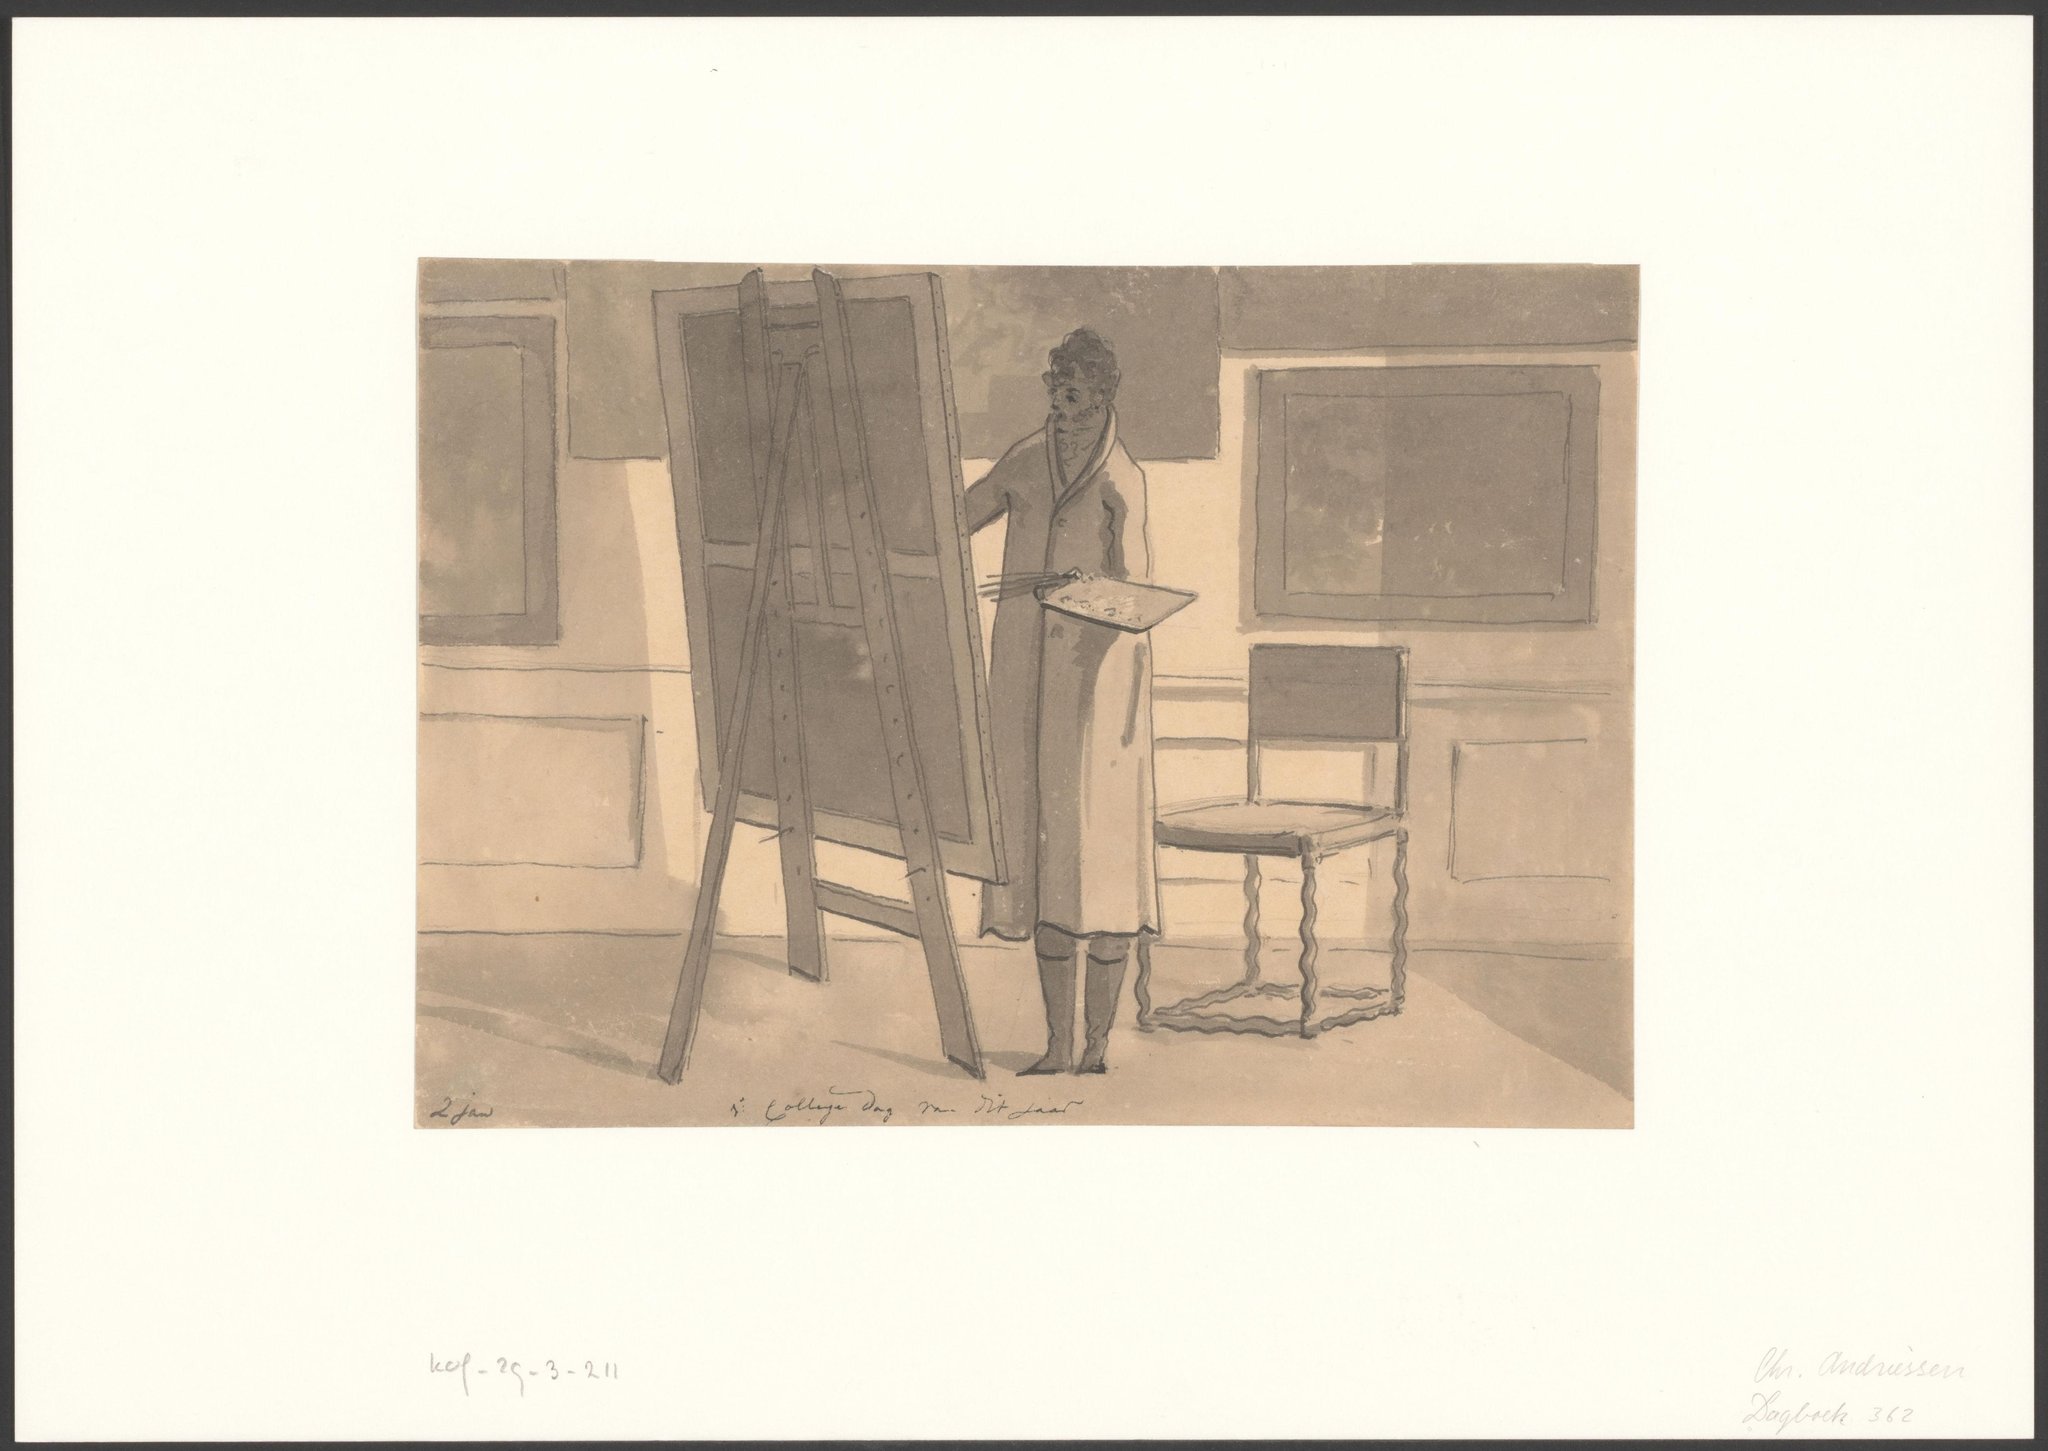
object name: drawing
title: Christiaan Andriessen schildert op de eerste bijeenkomst van het vrouwencollege in 1806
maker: christiaan andriessen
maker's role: draughtsman, print maker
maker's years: 1775-1846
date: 1806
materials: ink, paper, pencil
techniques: brush, pen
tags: amsterdam, print maker, draughtsman, christiaan andriessen, artist at work, in his workshop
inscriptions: inscription, signature: ‘J Andriessen’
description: Christiaan Andriessen richtte met zijn vader het Vrouwencollege op. Op de Tekenacademie, werden er alleen mannelijke naaktmodellen gebruikt. Daarom werden er in zijn huis lessen in naaktmodelstudies gegeven. Meisjes op straat in het centrum van Amsterdam werden benaderd of ze hiervoor tegen betaling model wilden staan.